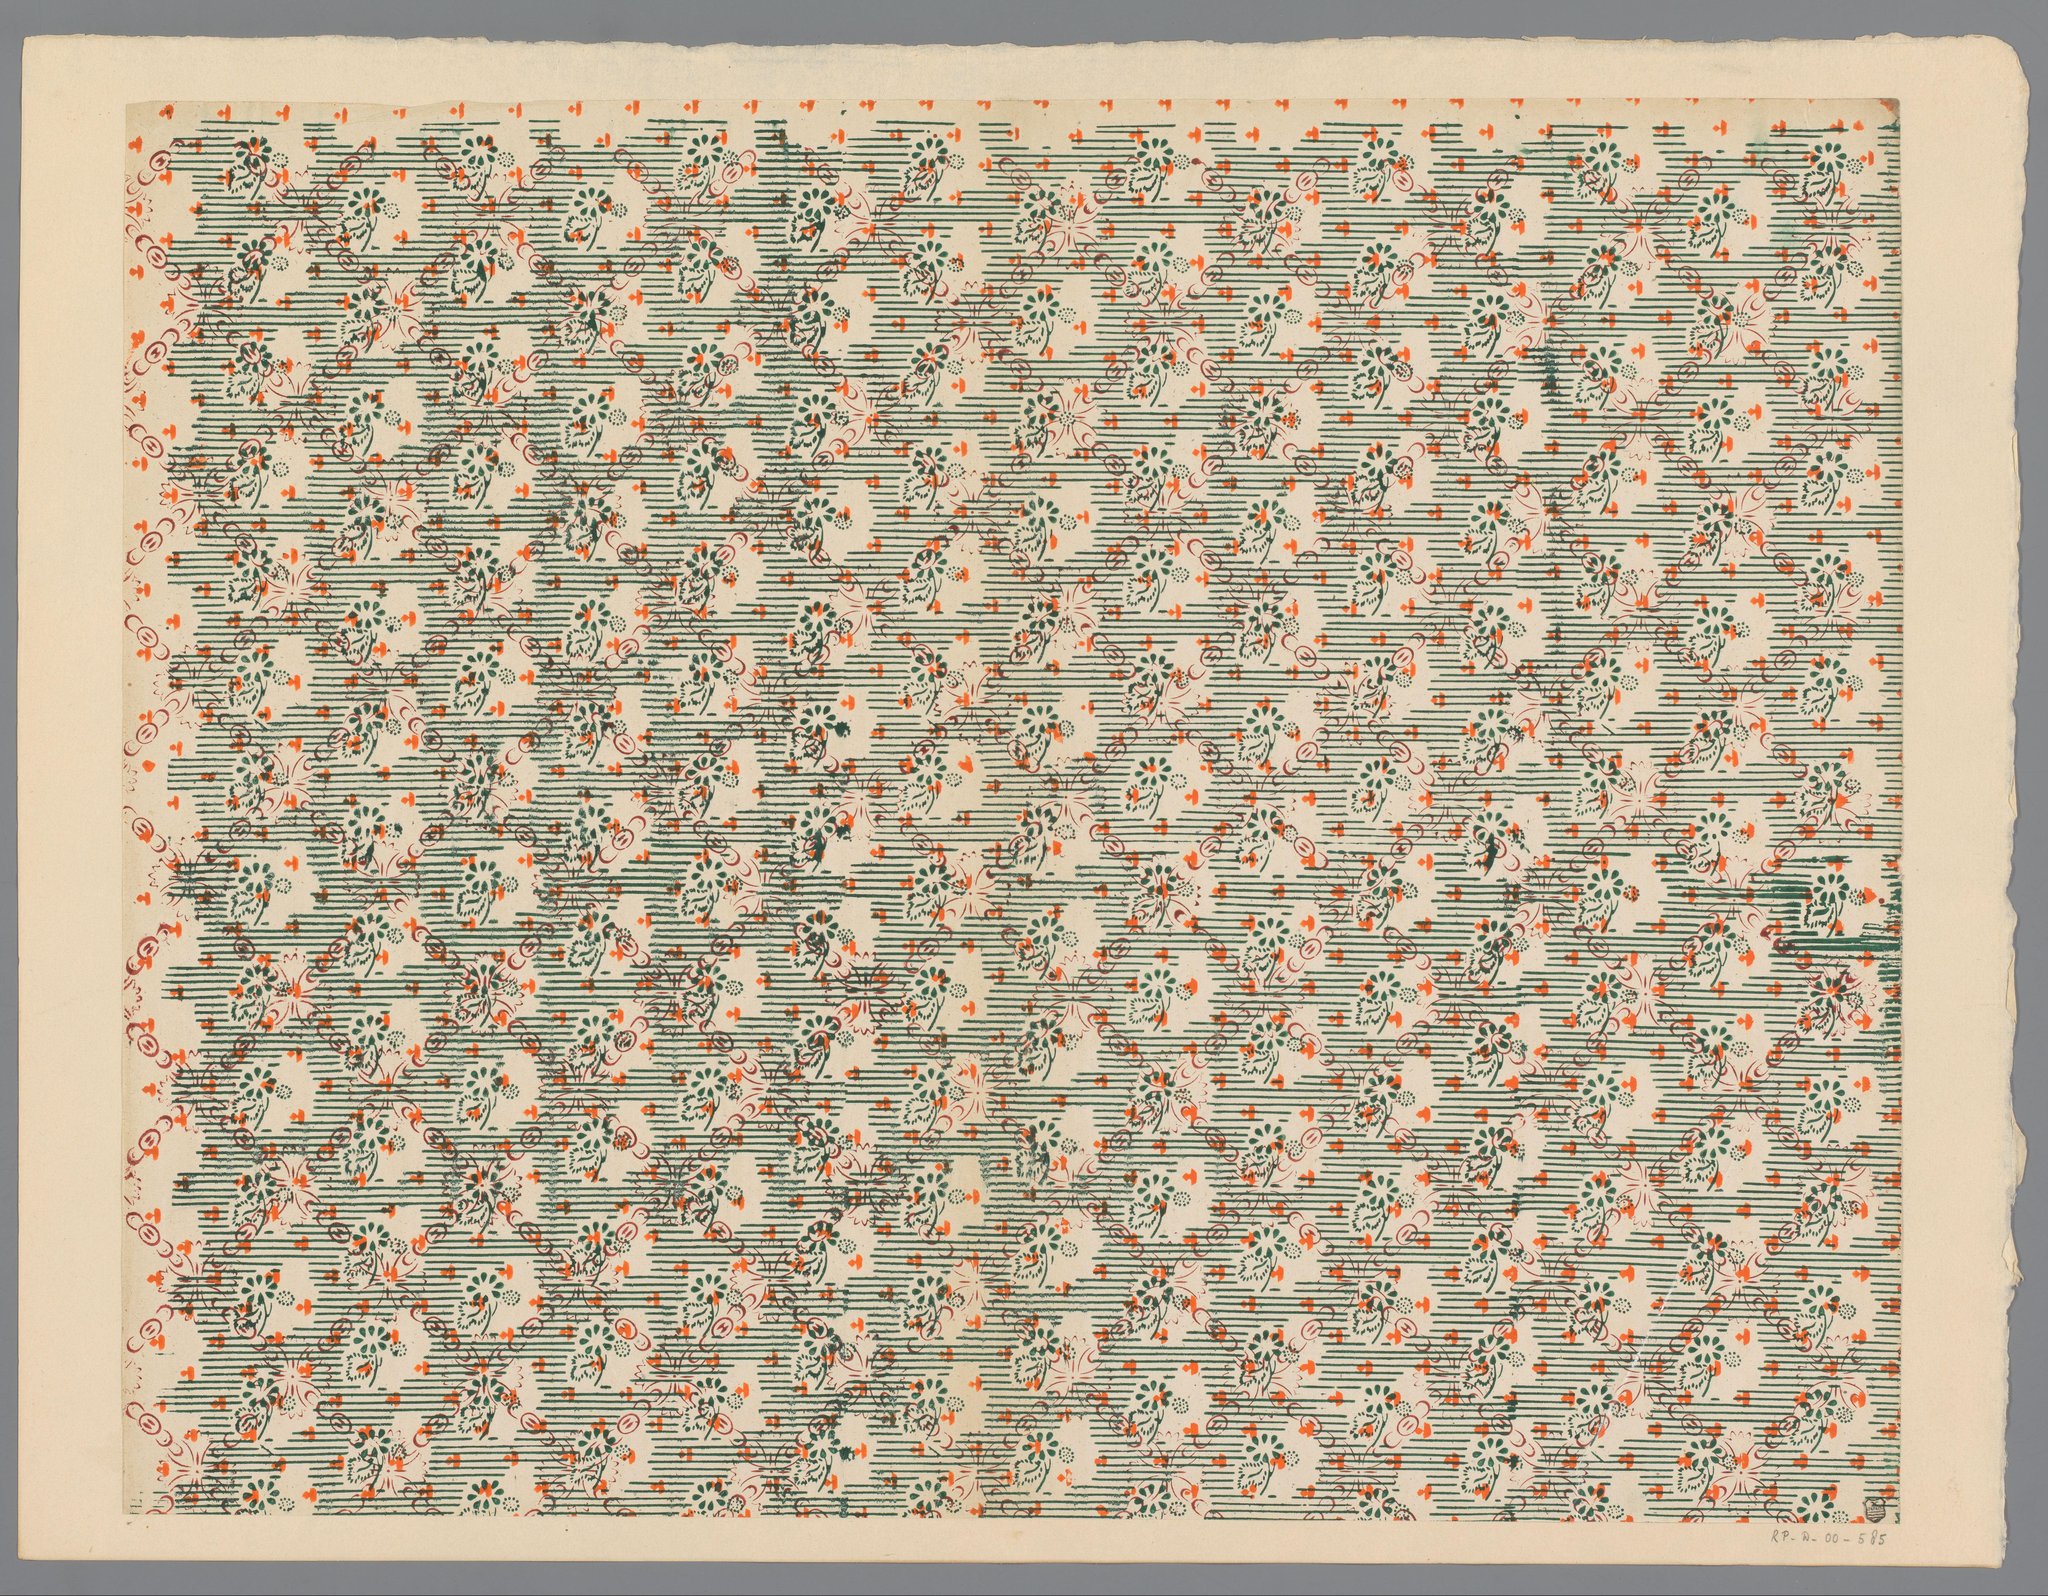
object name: printed paper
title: Blad met strooipatroon van bloemen en onderbroken lijnenfond en ruitenpatroon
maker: Anonymous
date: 1800-1900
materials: paper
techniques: printing block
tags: ornament derived from plant forms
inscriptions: collector's mark: Lugt 2760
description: Blad met strooipatroon van bloemen en onderbroken horizontaal lijnenfond en ruitenpatroon.